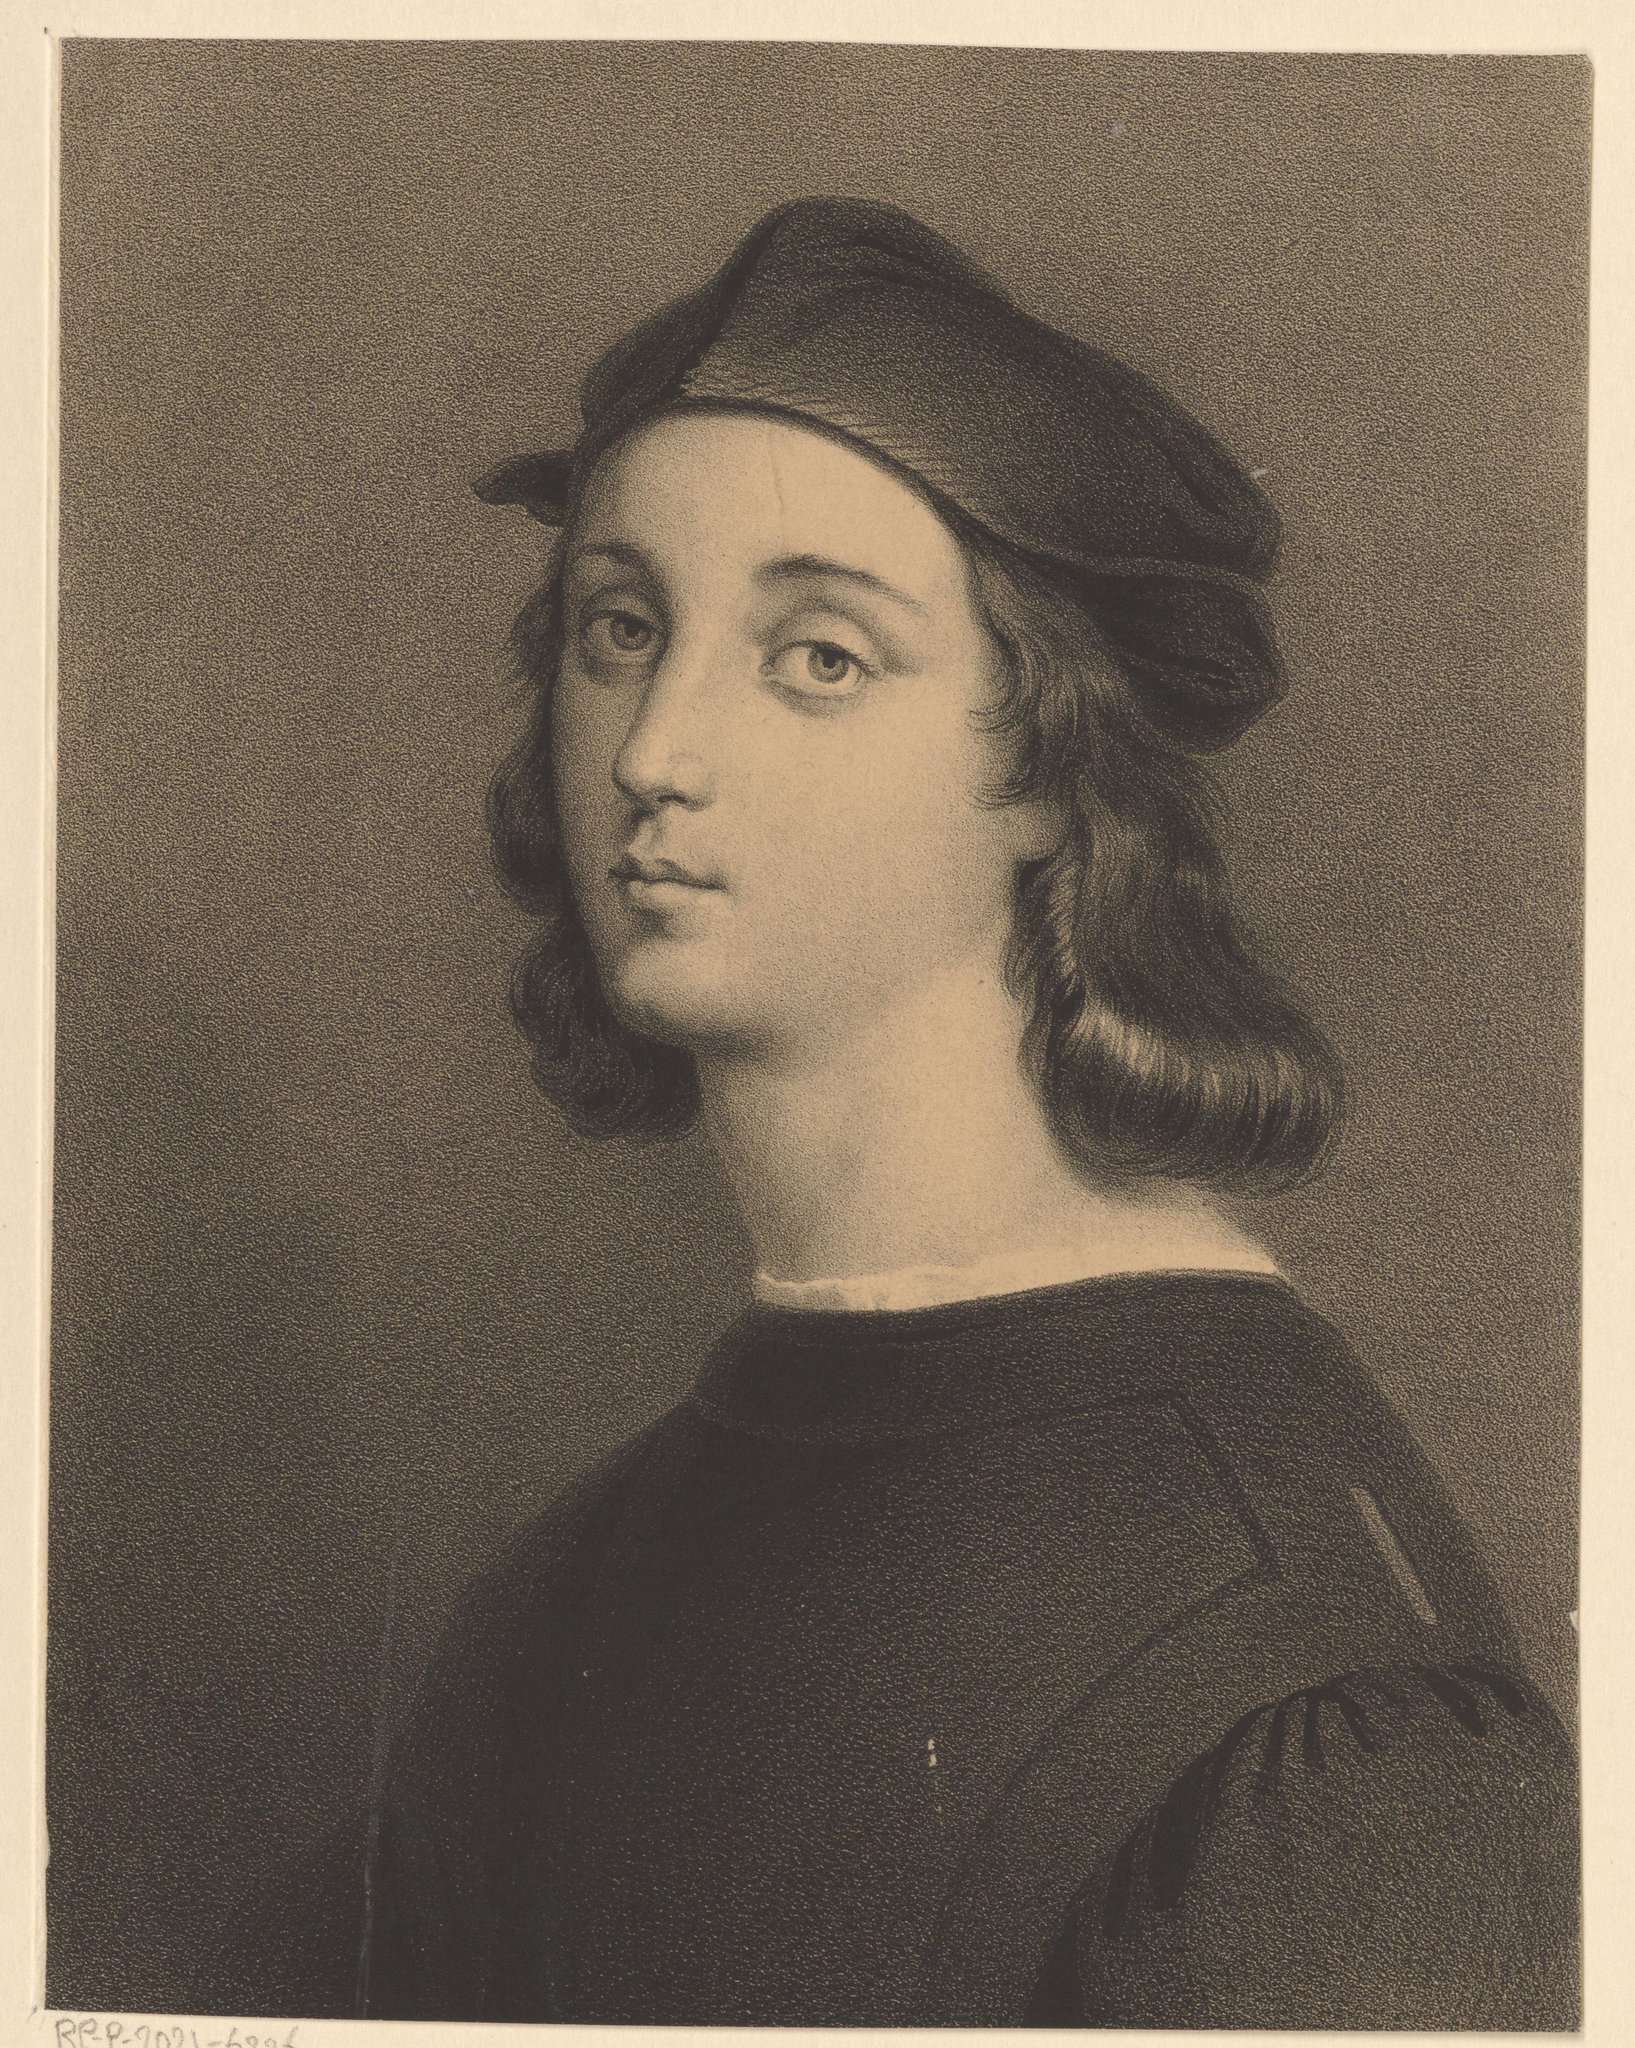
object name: print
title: Portret van Rafaël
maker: Anonymous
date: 1795-1899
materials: paper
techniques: lithograph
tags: rome, painter, rafaël, historical persons, portrait, self-portrait of painter